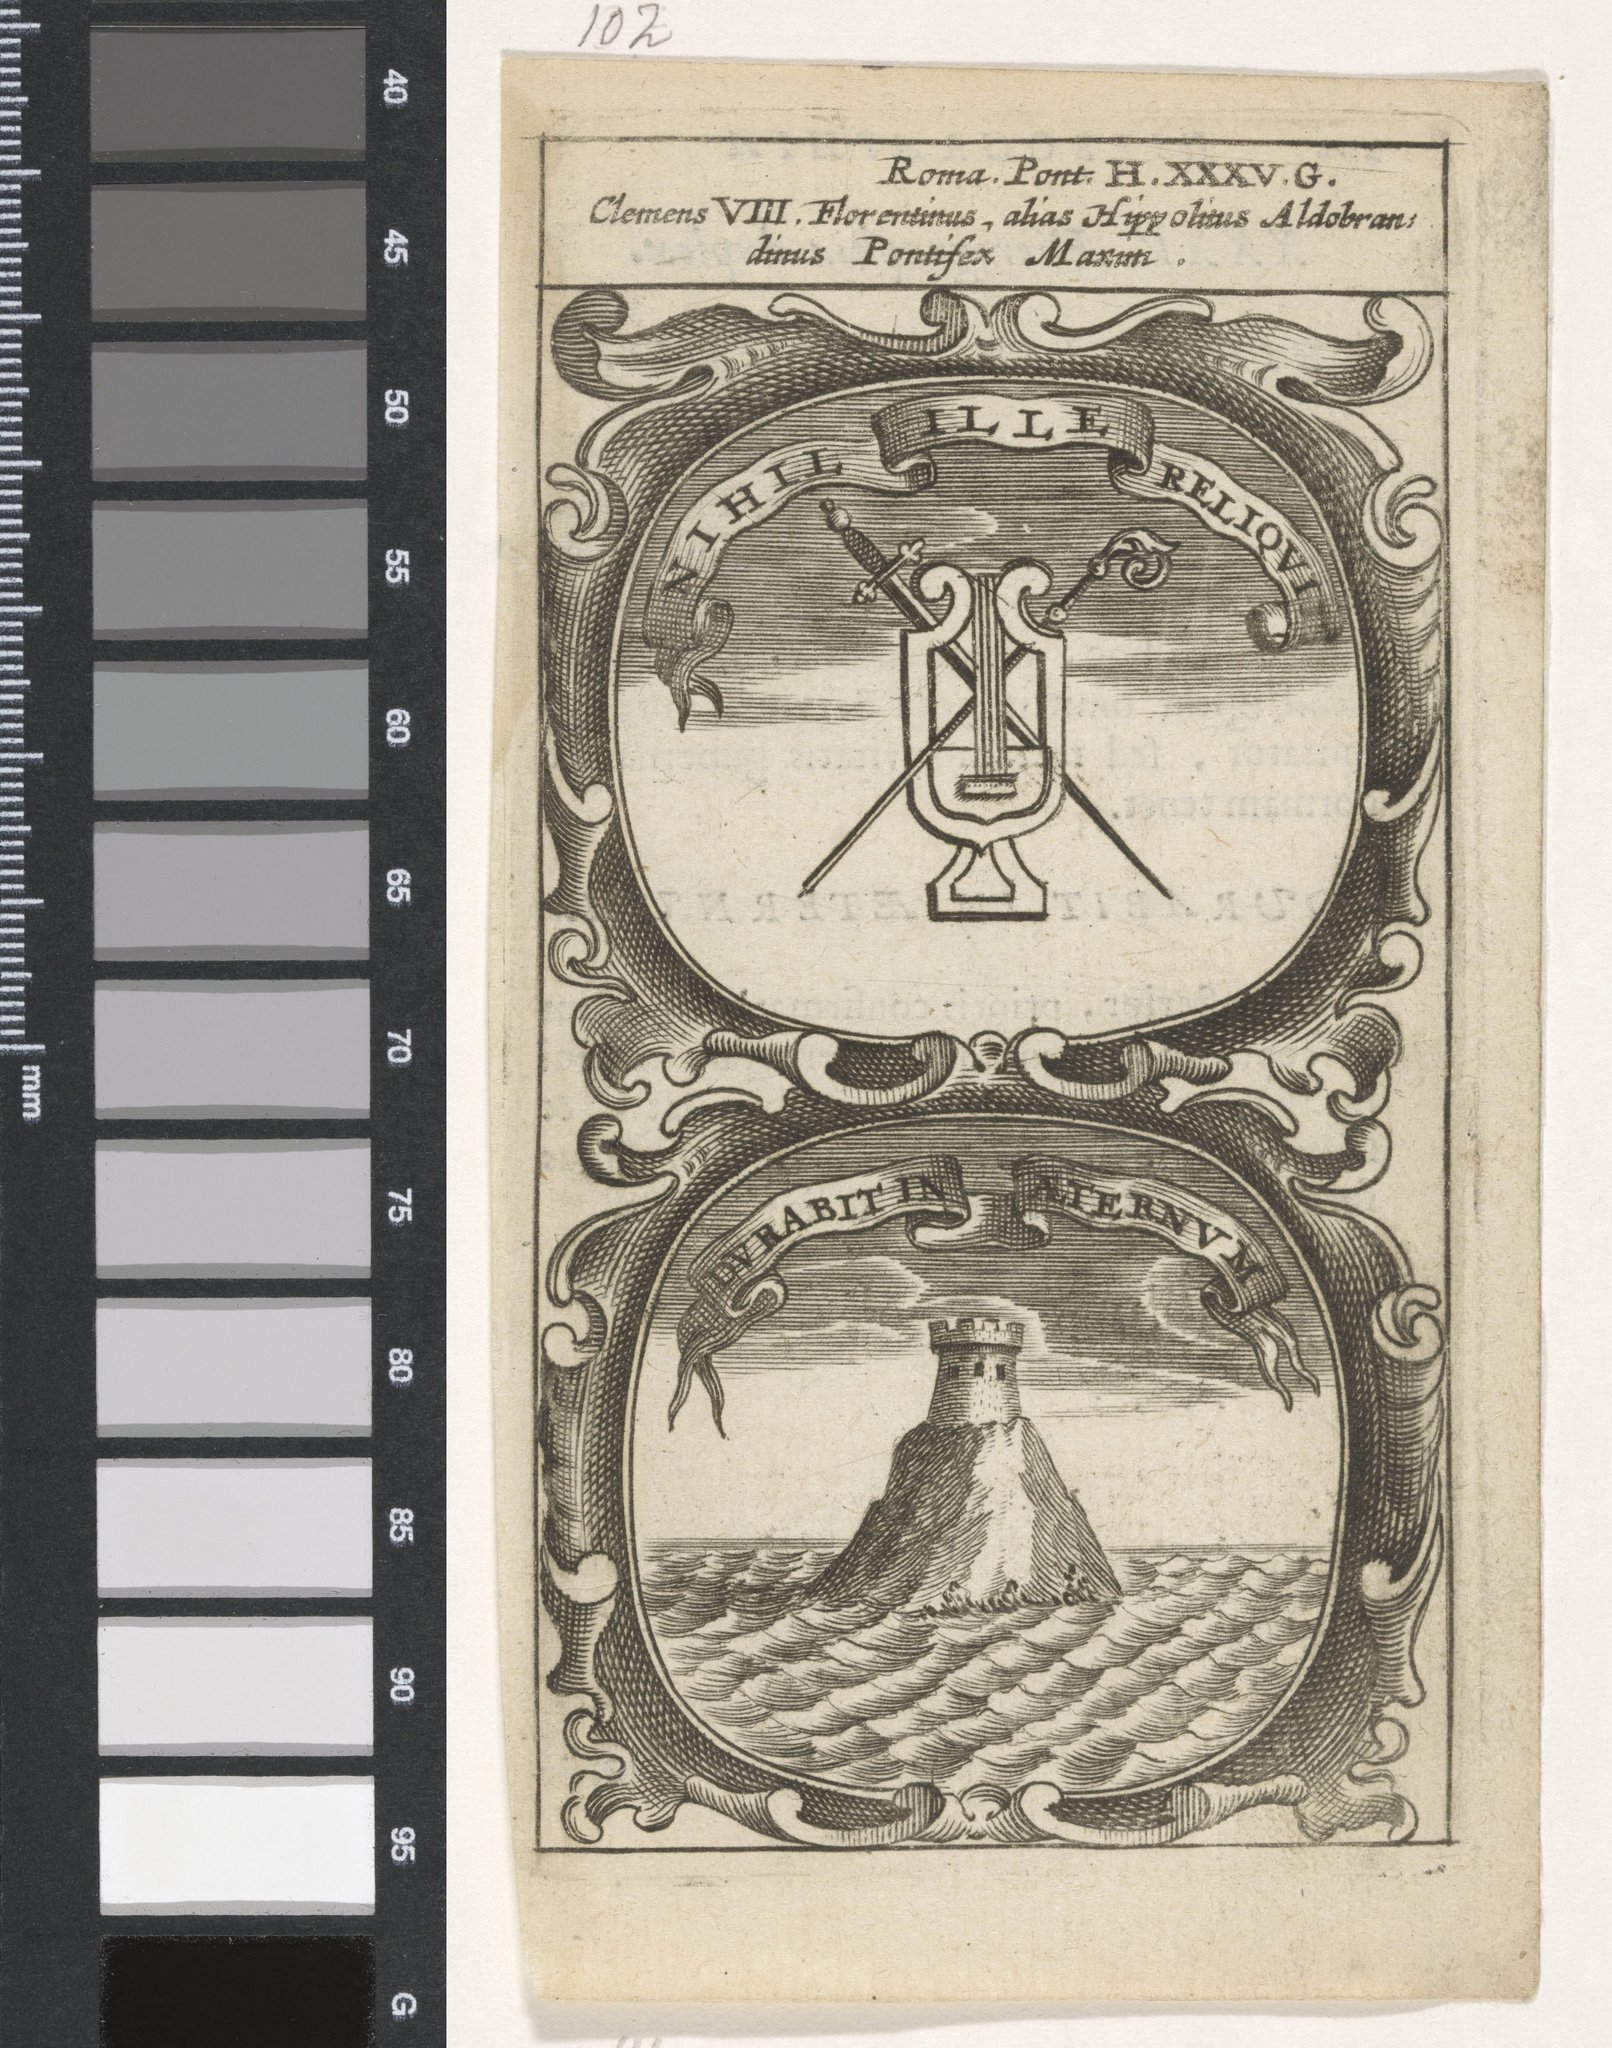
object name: print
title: Symbola Divina et Humana Pontificum Imperatorum Regum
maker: Anonymous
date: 1666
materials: paper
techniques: engraving, letterpress printing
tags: rome, clemens viii, hacking and thrusting weapons: sword, harp, landscape with tower or castle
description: Pagina uit Jacob Typotius, Symbola Divina & Humana Pontificum Imperatorum Regum. Arnhem, J.F. Hagen, 1666 of uit de titeluitgave van 1669 of 1679. Het werk van Typotius werd voor het eerst uitgegeven in 1601 met prenten van Aegidius Sadeler.